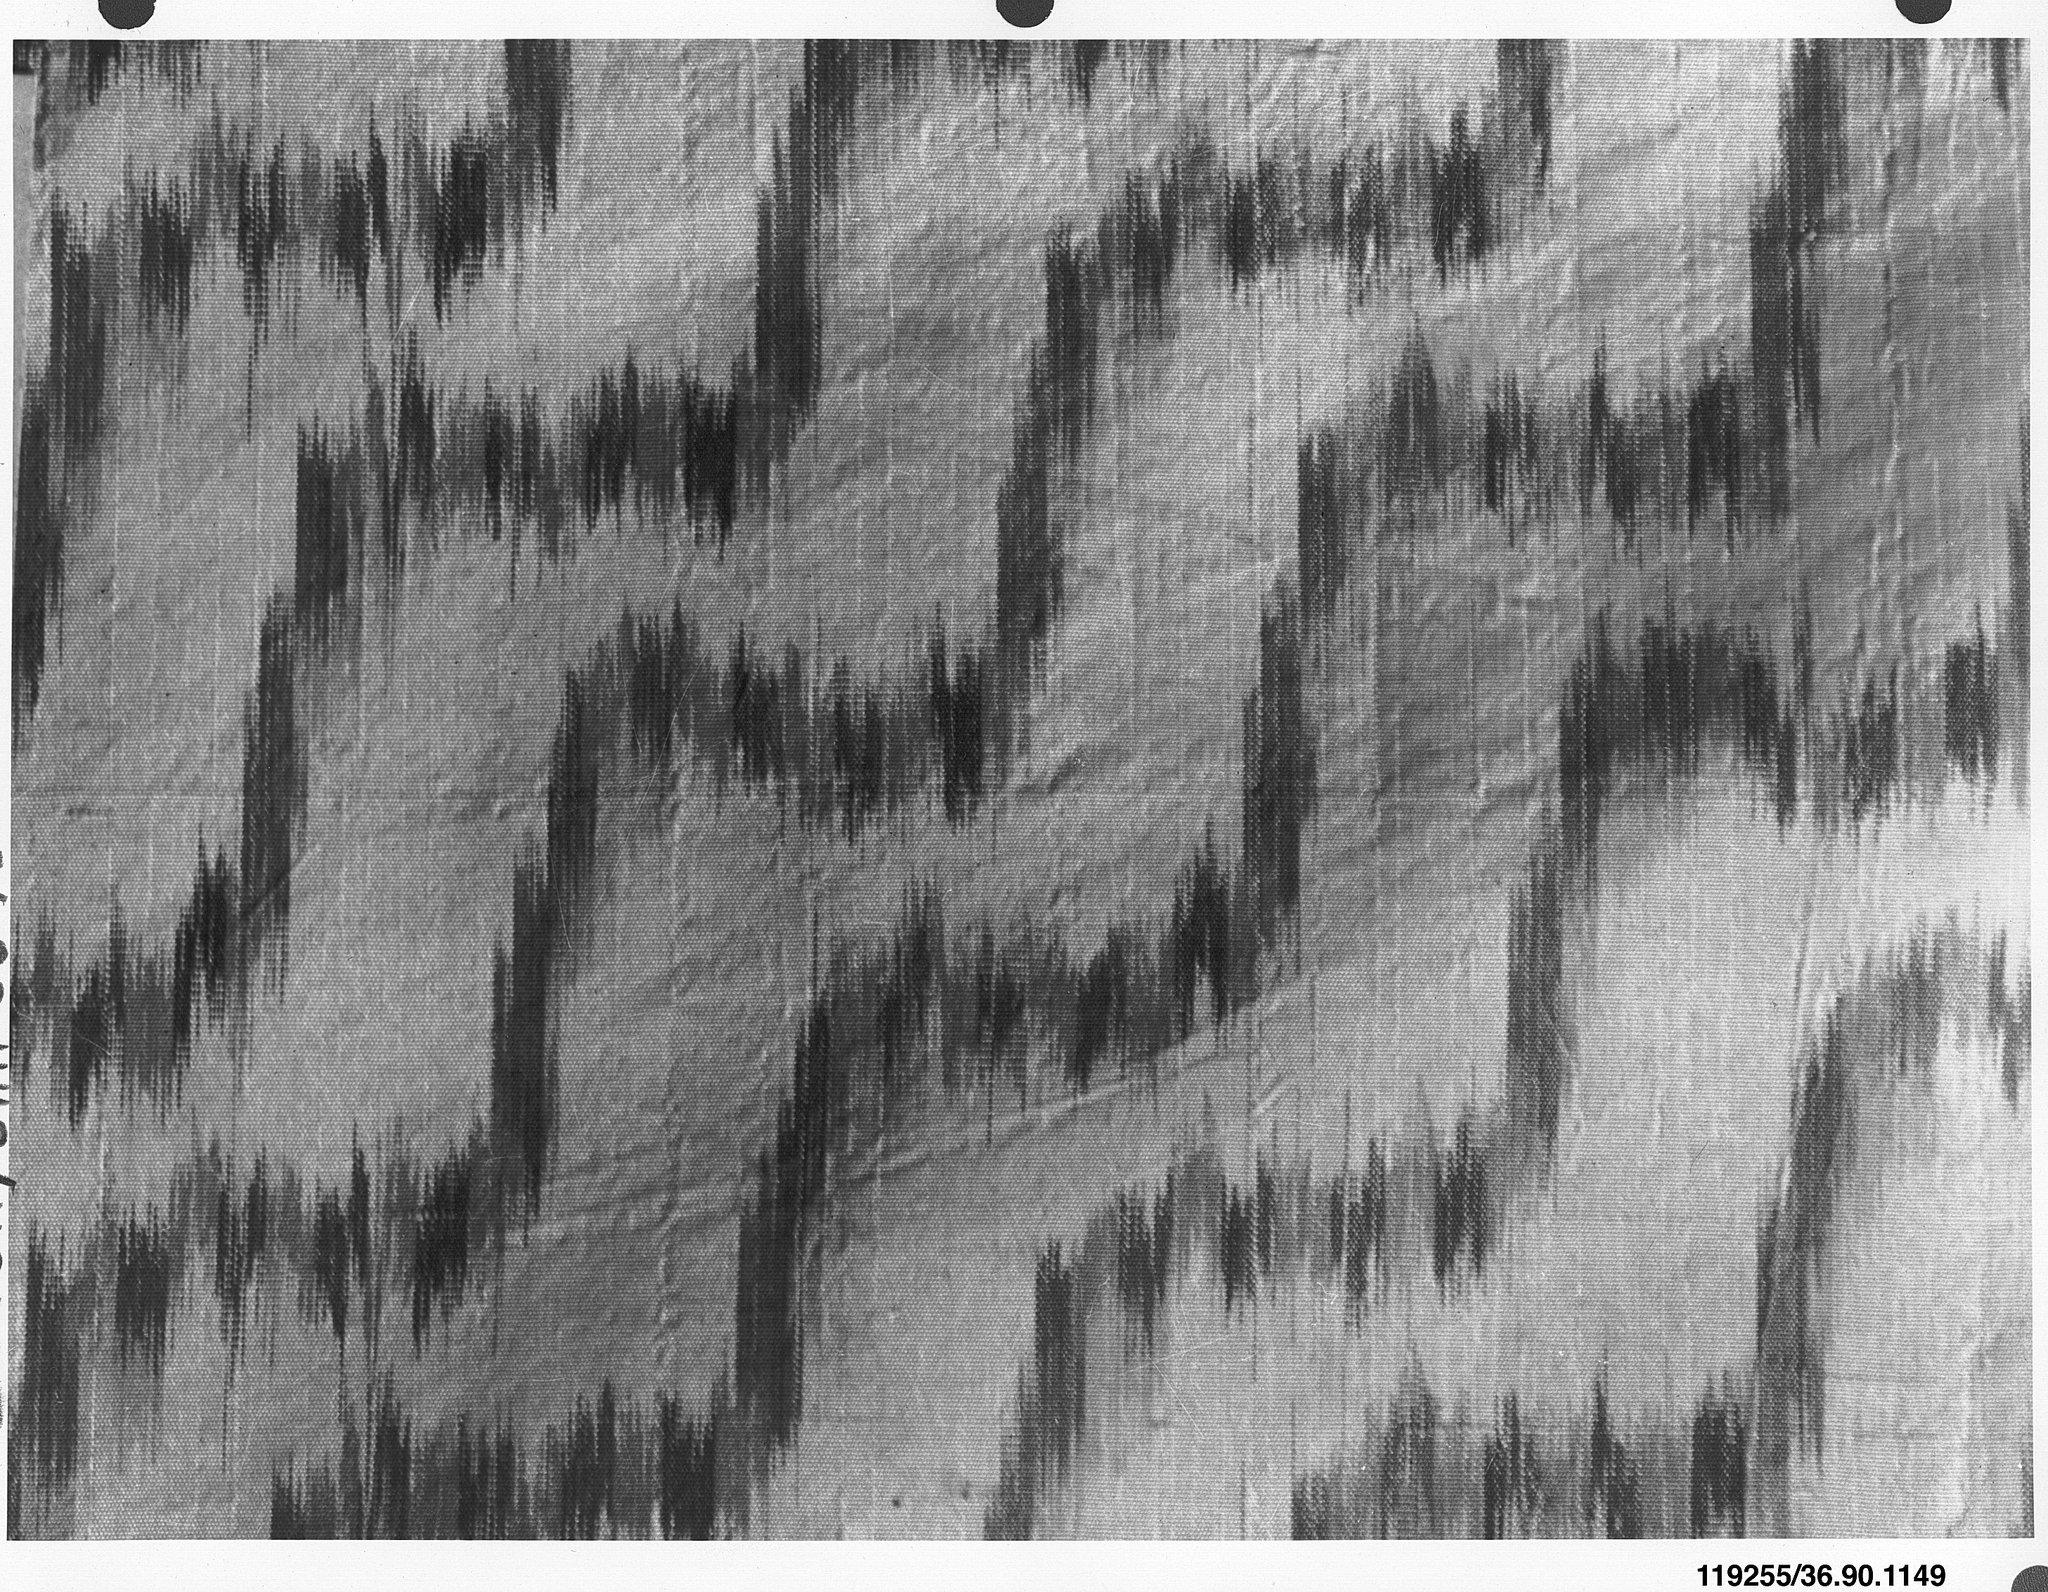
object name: piece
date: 1701-1800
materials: silk